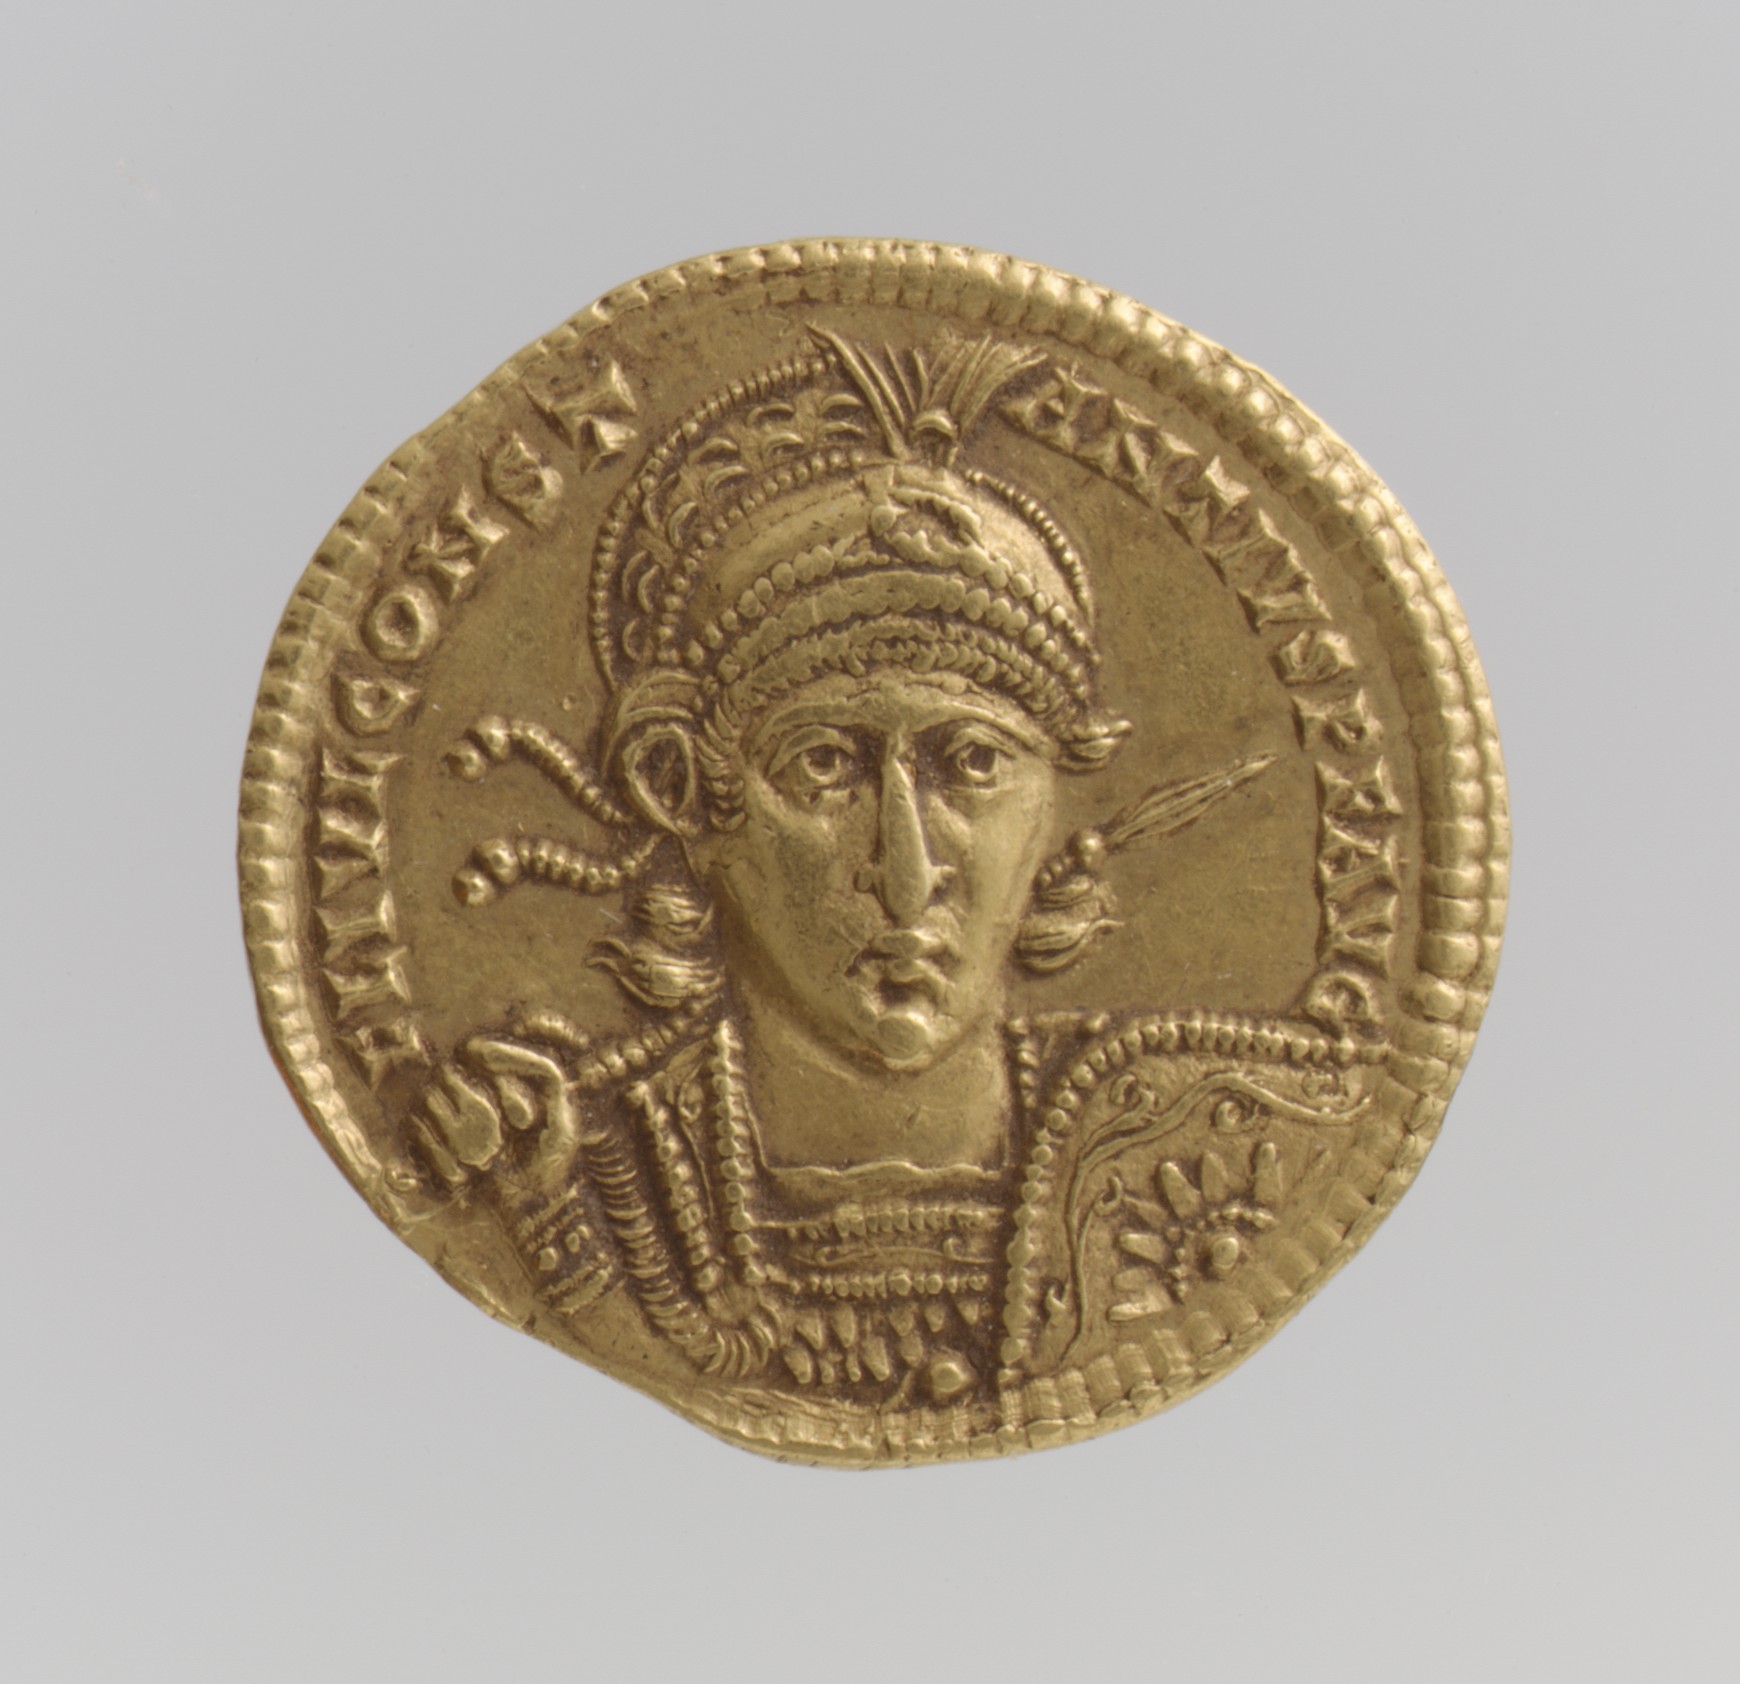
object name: solidus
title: Gold Solidus of Constantine II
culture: byzantine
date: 337-361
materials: gold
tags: emperors,men